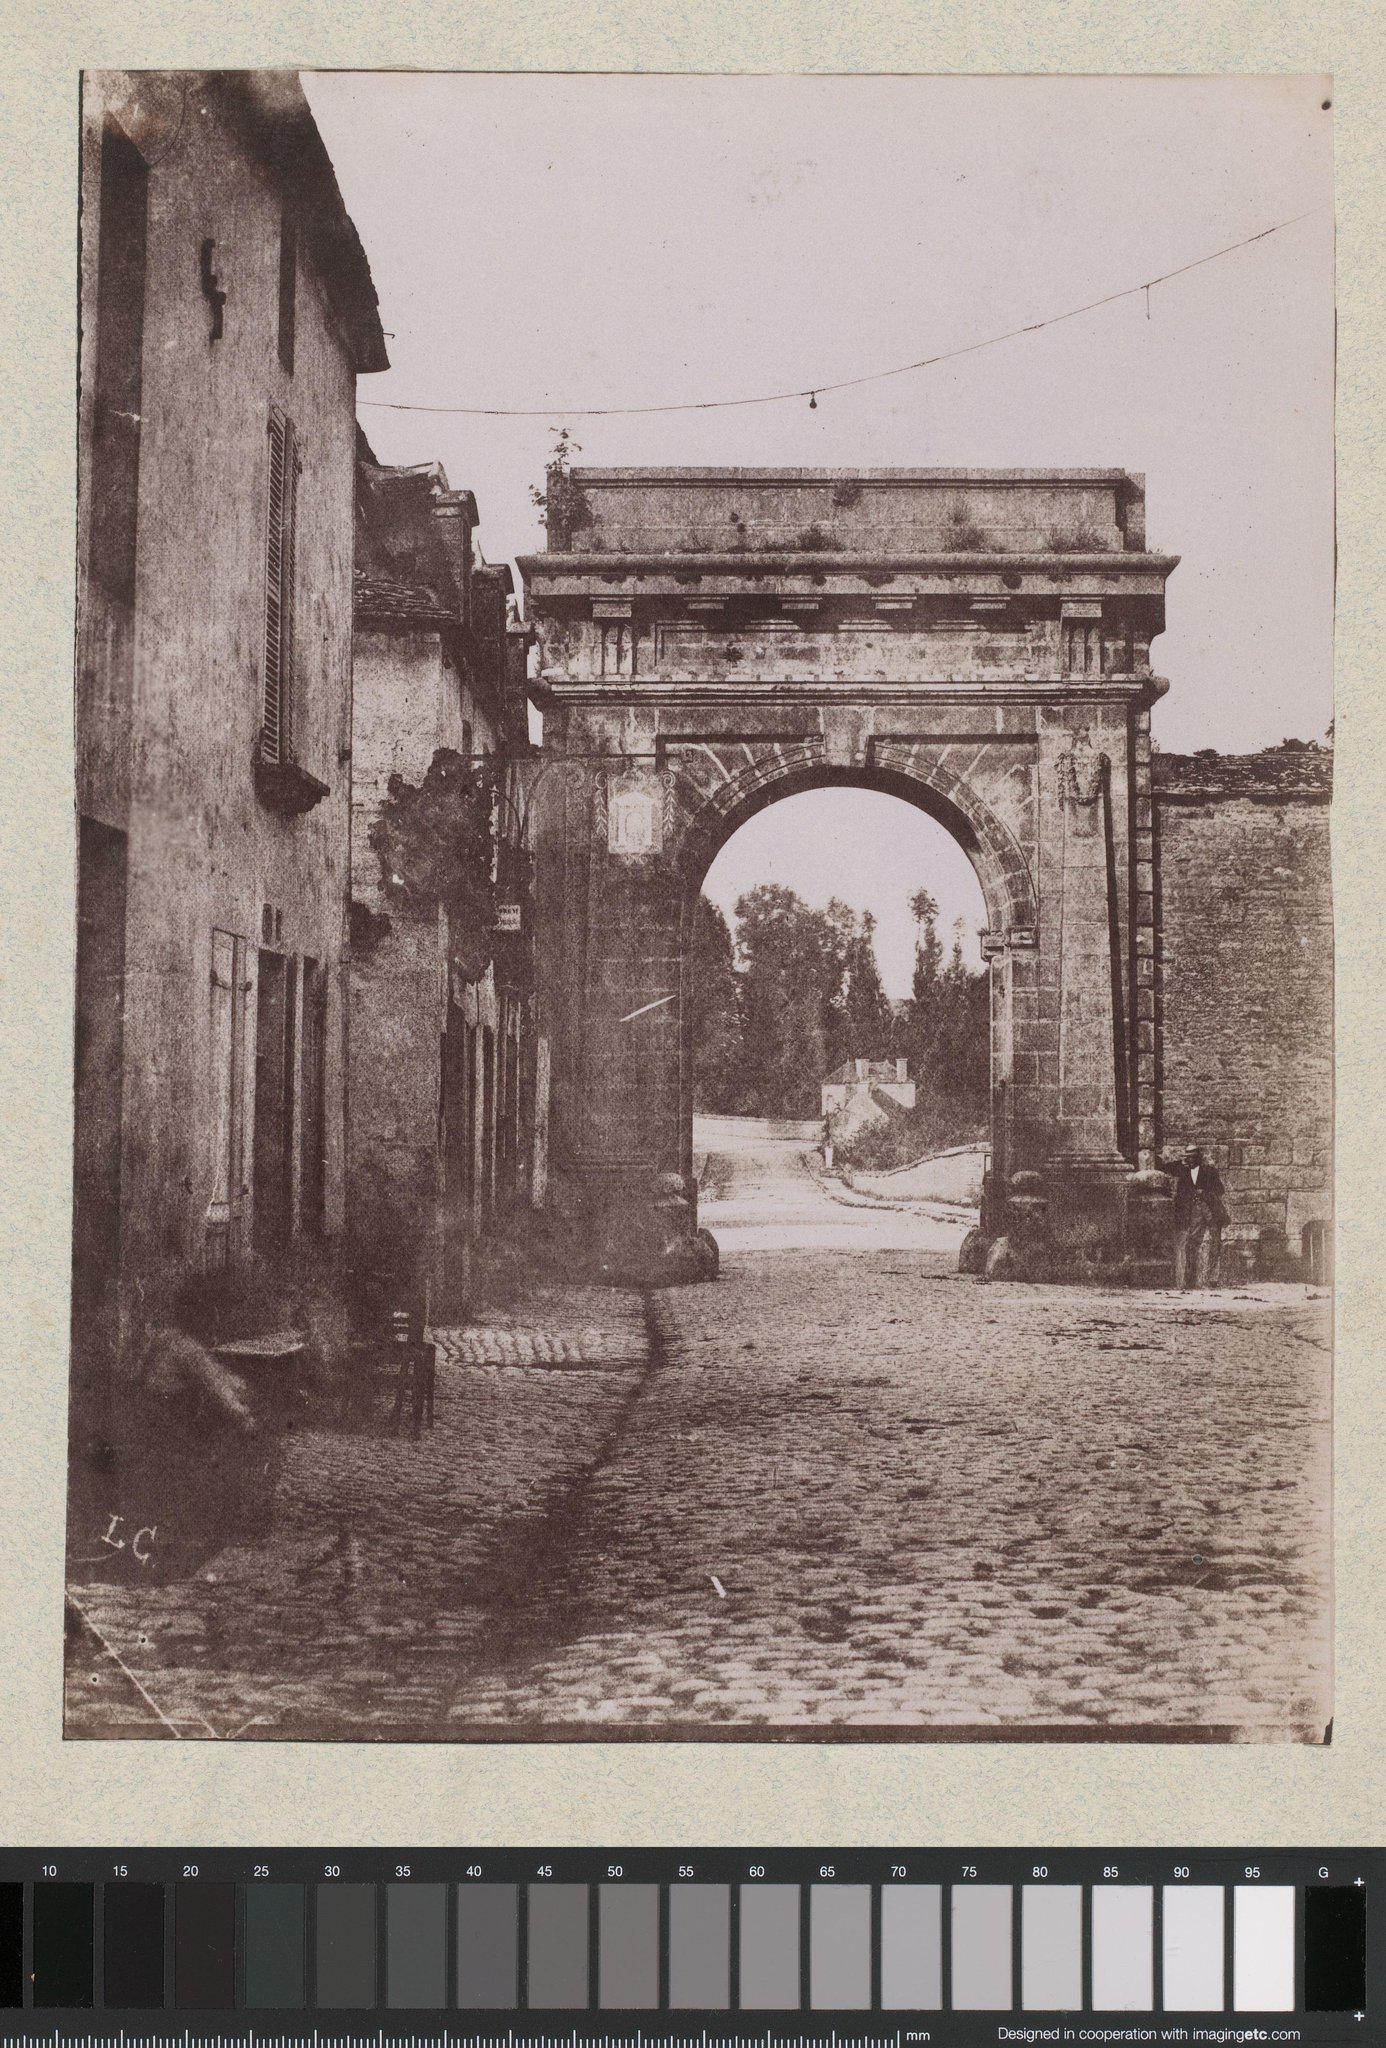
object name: photograph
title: Gezicht op een poort vanaf een binnenplaats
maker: lc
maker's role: fotograaf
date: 1851-1900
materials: paper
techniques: albumen print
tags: gate, entrance, courtyard